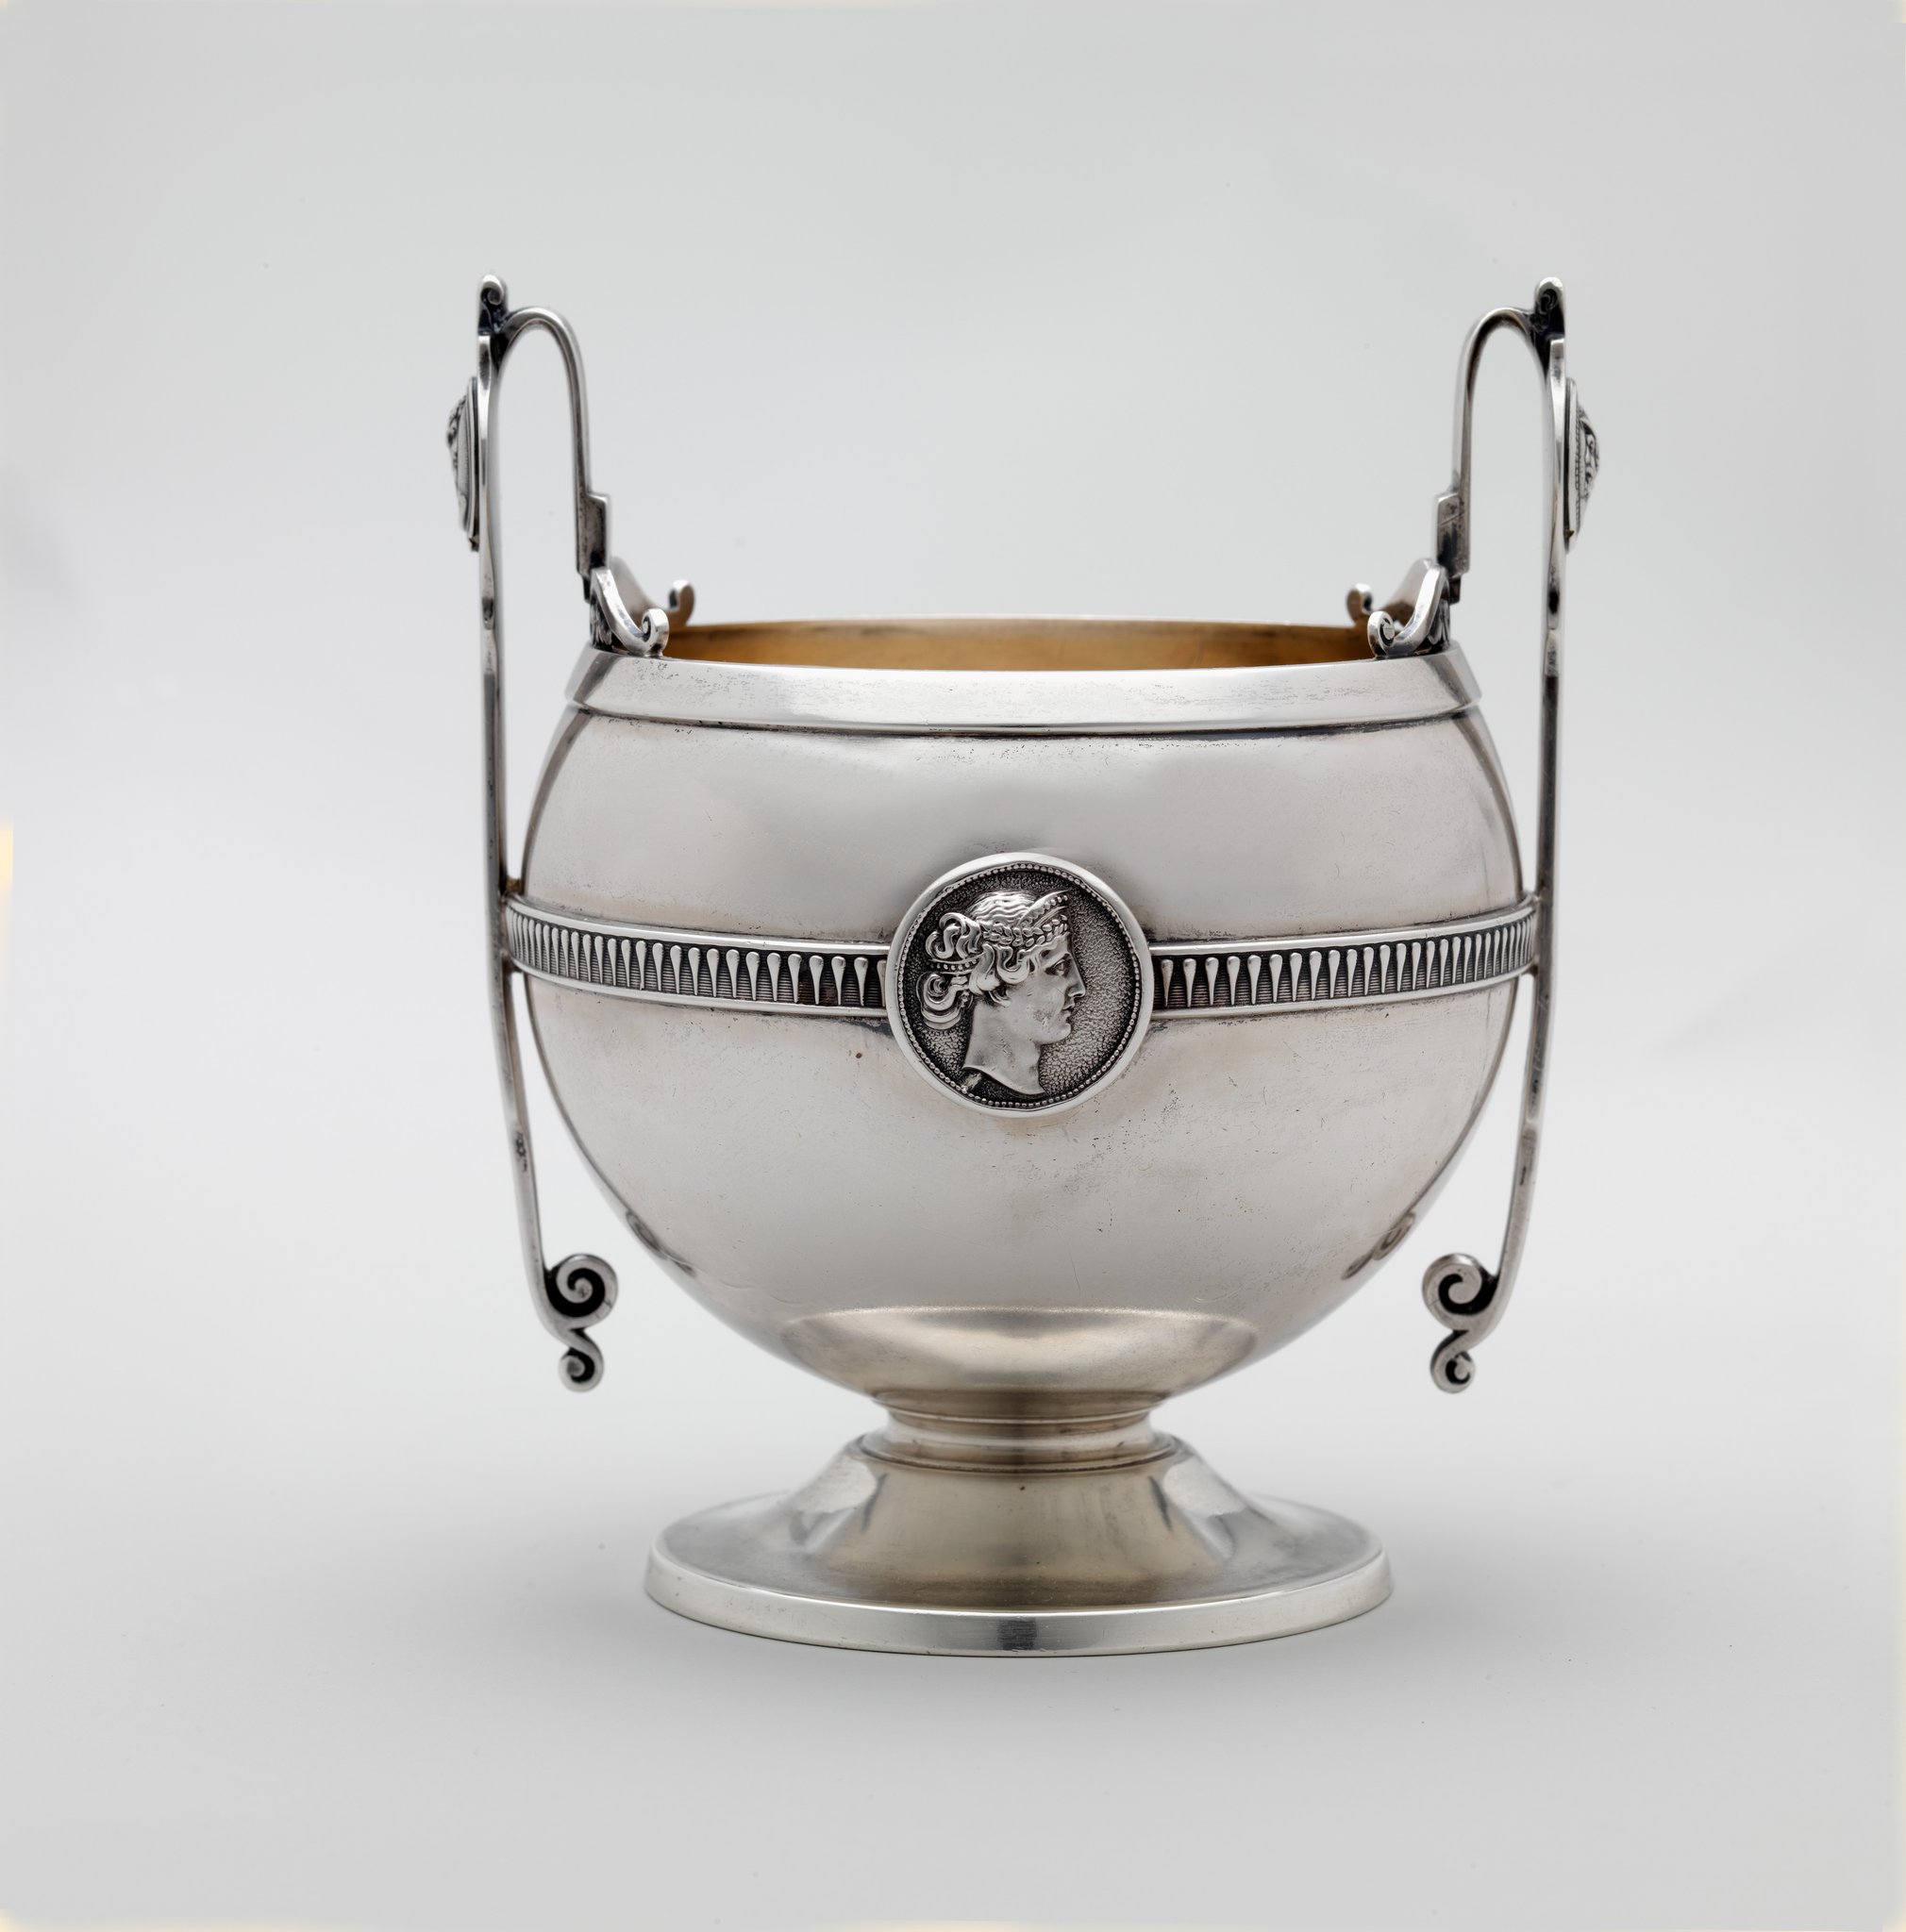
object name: sugar bowl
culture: american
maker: gorham manufacturing company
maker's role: maker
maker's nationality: american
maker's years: 1831-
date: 1865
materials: silver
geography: united states